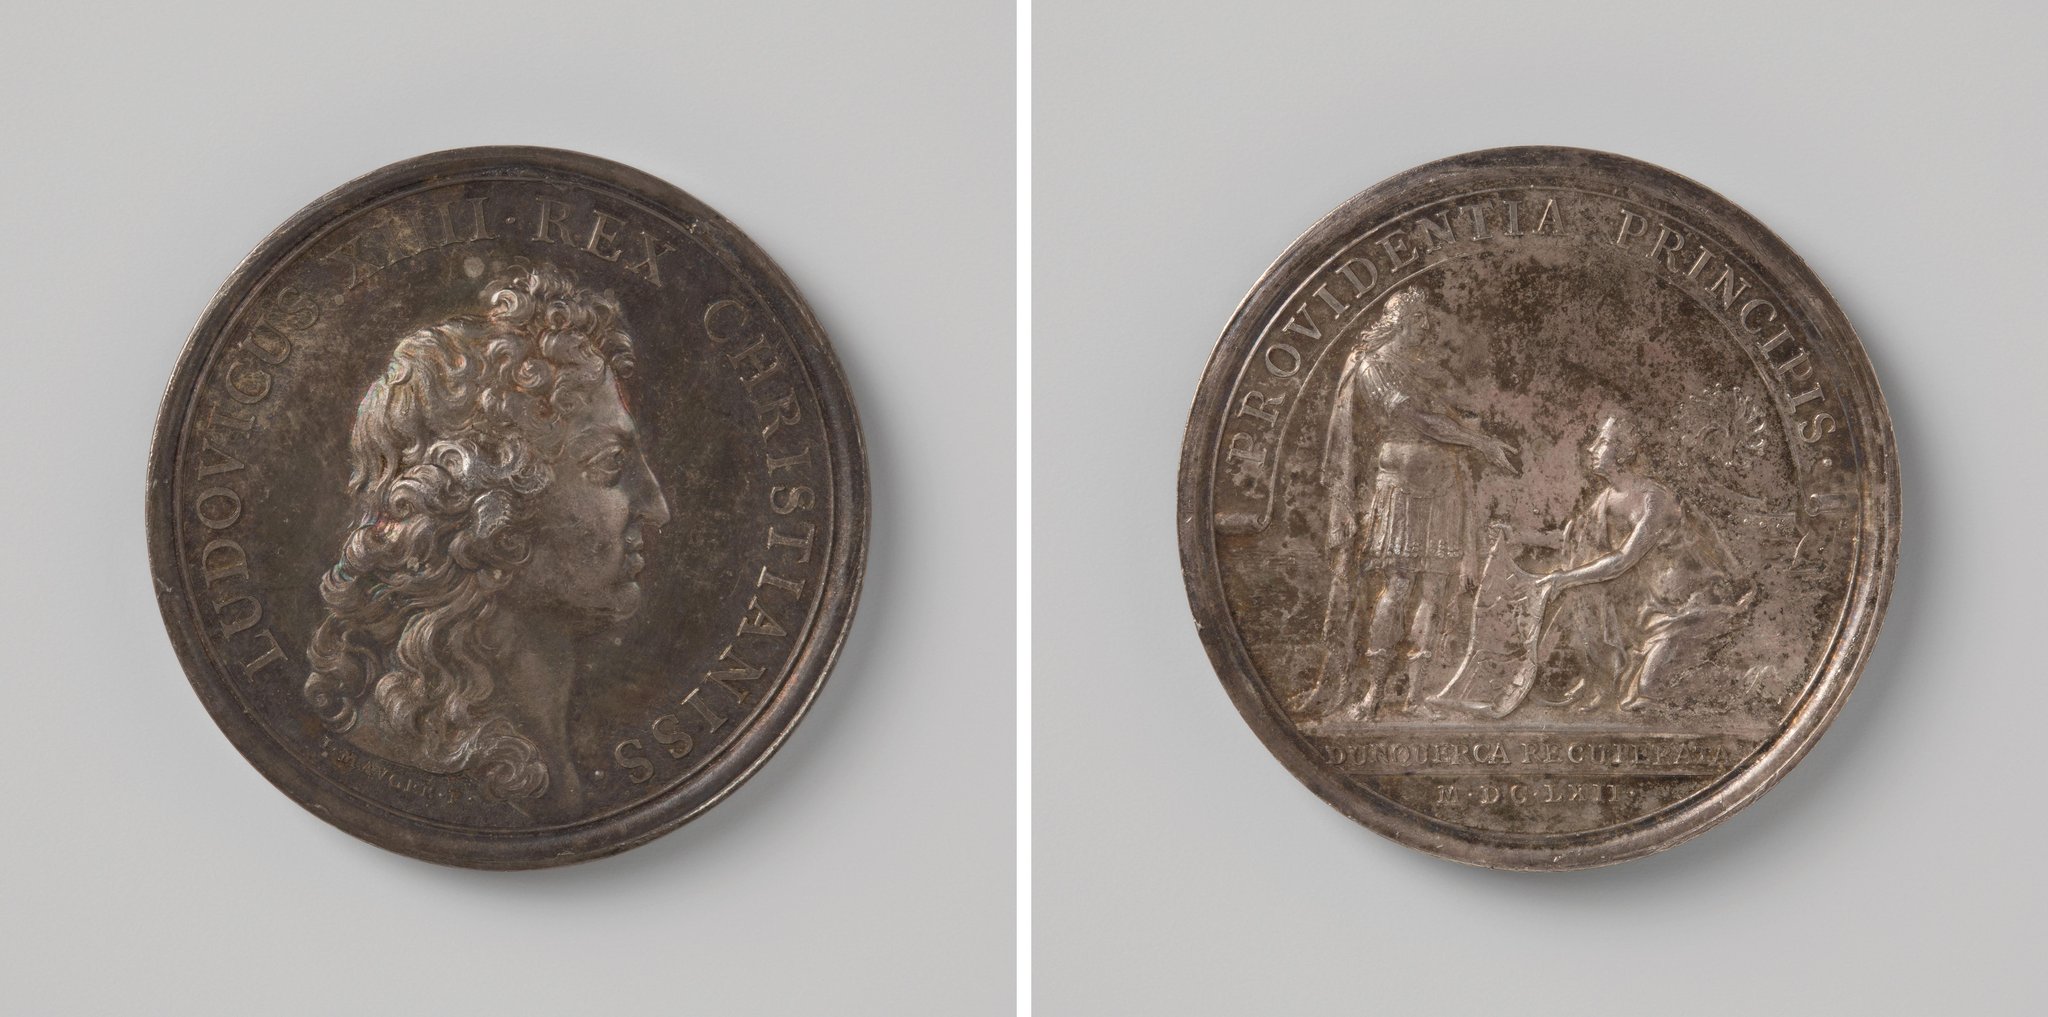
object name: history medal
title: Duinkerken door de Fransen gekocht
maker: jean mauger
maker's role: medailleur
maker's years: 1648-1722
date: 1699-1703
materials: silver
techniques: striking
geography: paris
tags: lodewijk xiv (koning van frankrijk), france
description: Zilveren penning. Voorzijde: borststuk jongeman (Lodewijk XIV) binnen omschrift. Keerzijde: Duinkerken in gedaante van knielende vrouw biedt Frankrijk plattegrond van stad aan binnen omschrift; afsnede: opschrift